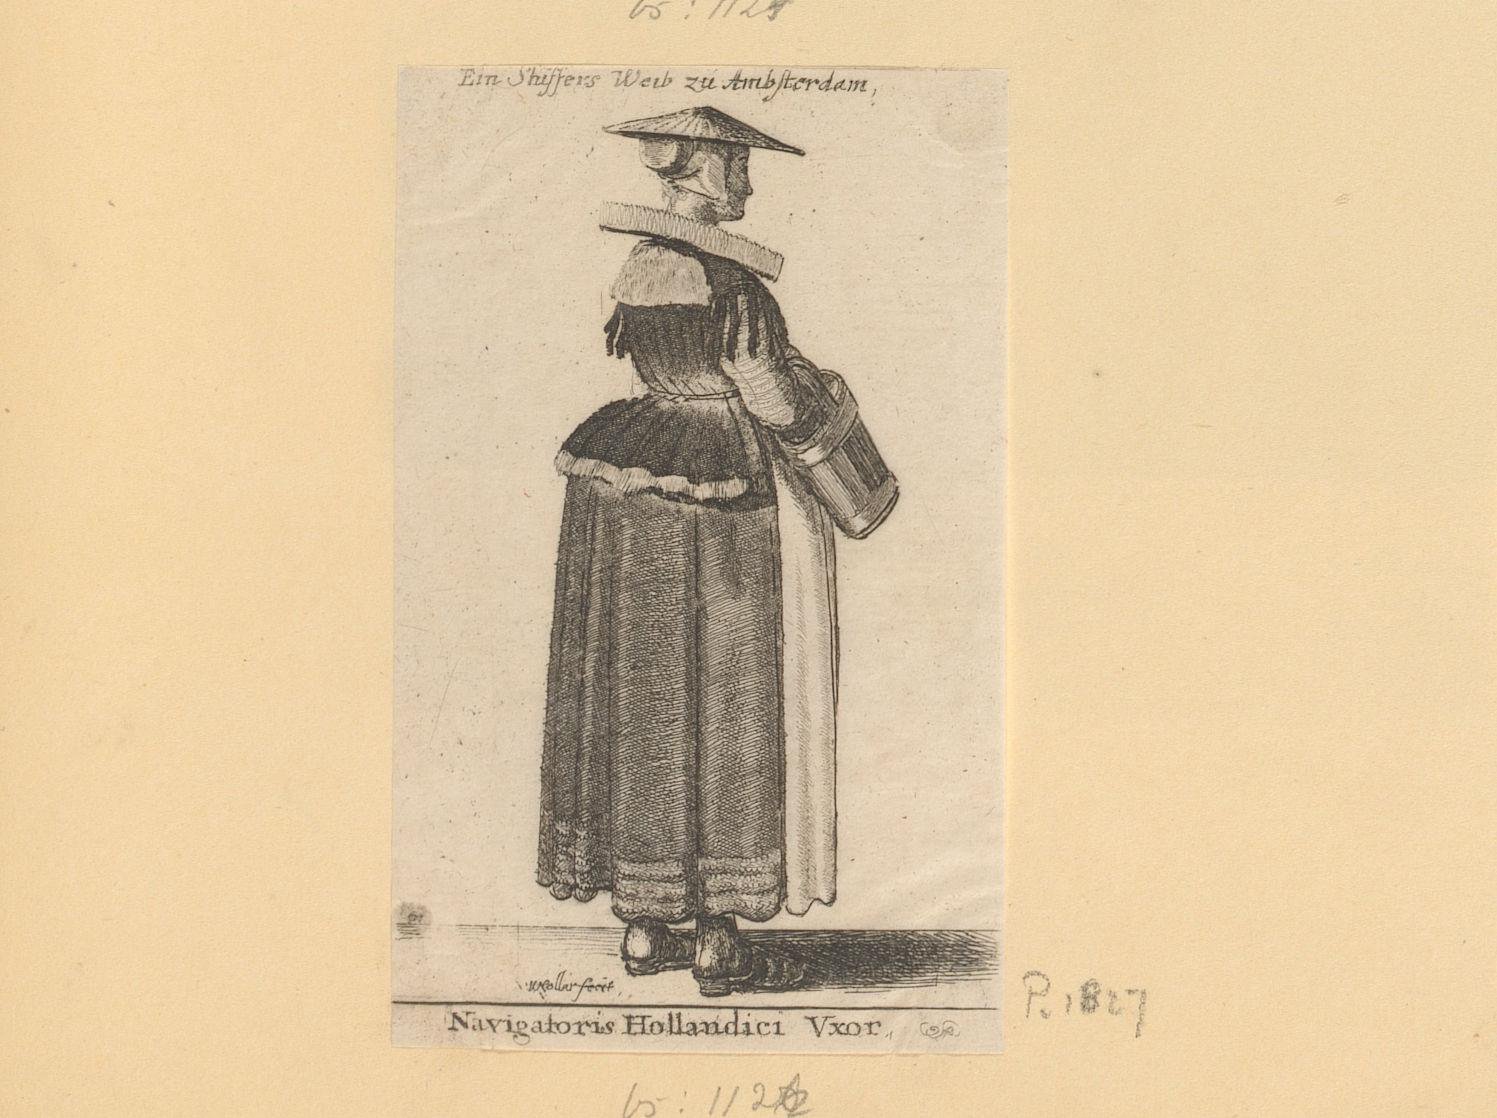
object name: album leaf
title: Theatrum Mulierum / Aula Veneris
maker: wenceslaus hollar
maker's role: draughtsman, print maker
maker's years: 1607-1677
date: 1643-1649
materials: paper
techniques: etching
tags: adult woman, folk costume, regional costume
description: Prent maakt mogelijk deel uit van een serie van 200 prenten. Deze serie is onder de titel 'A Collection of two hundred original etchings' voor het eerst uitgegeven door J.M. Greery in 1816.